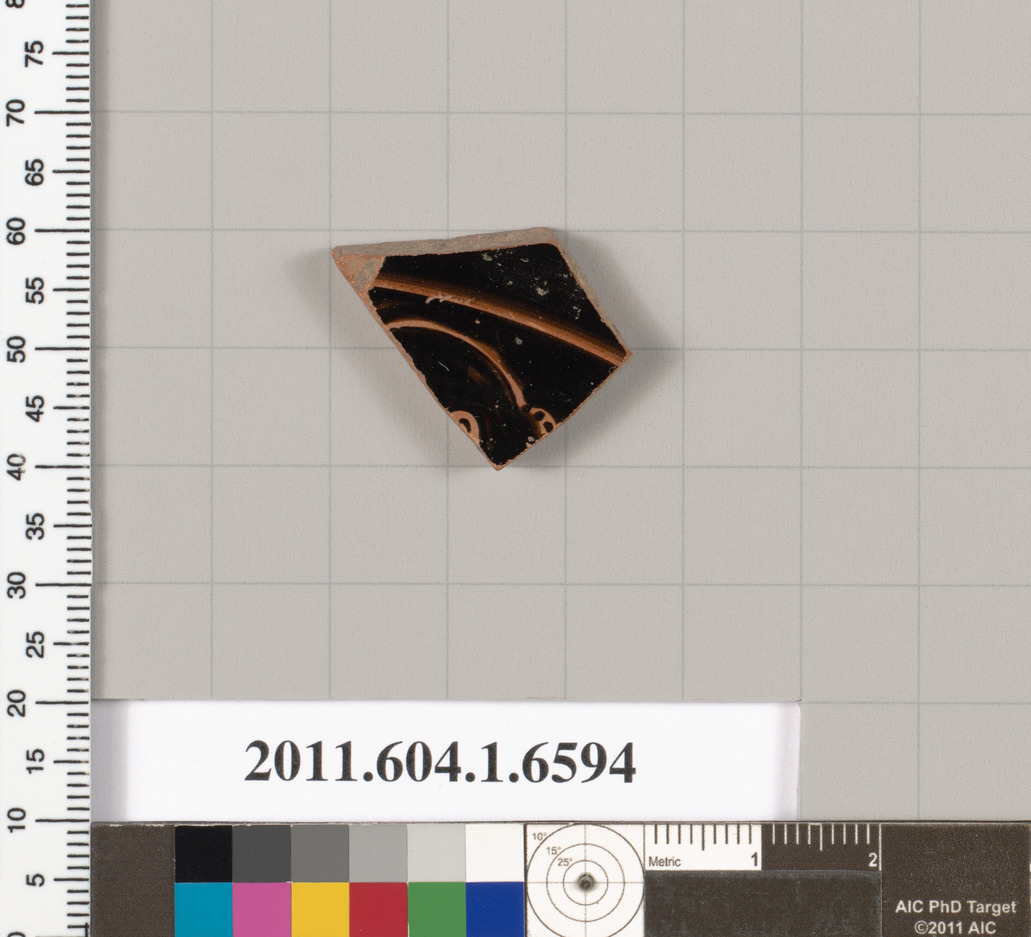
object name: kylix fragment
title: Terracotta fragment of a kylix (drinking cup)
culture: greek, attic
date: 490-480 BCE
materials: terracotta